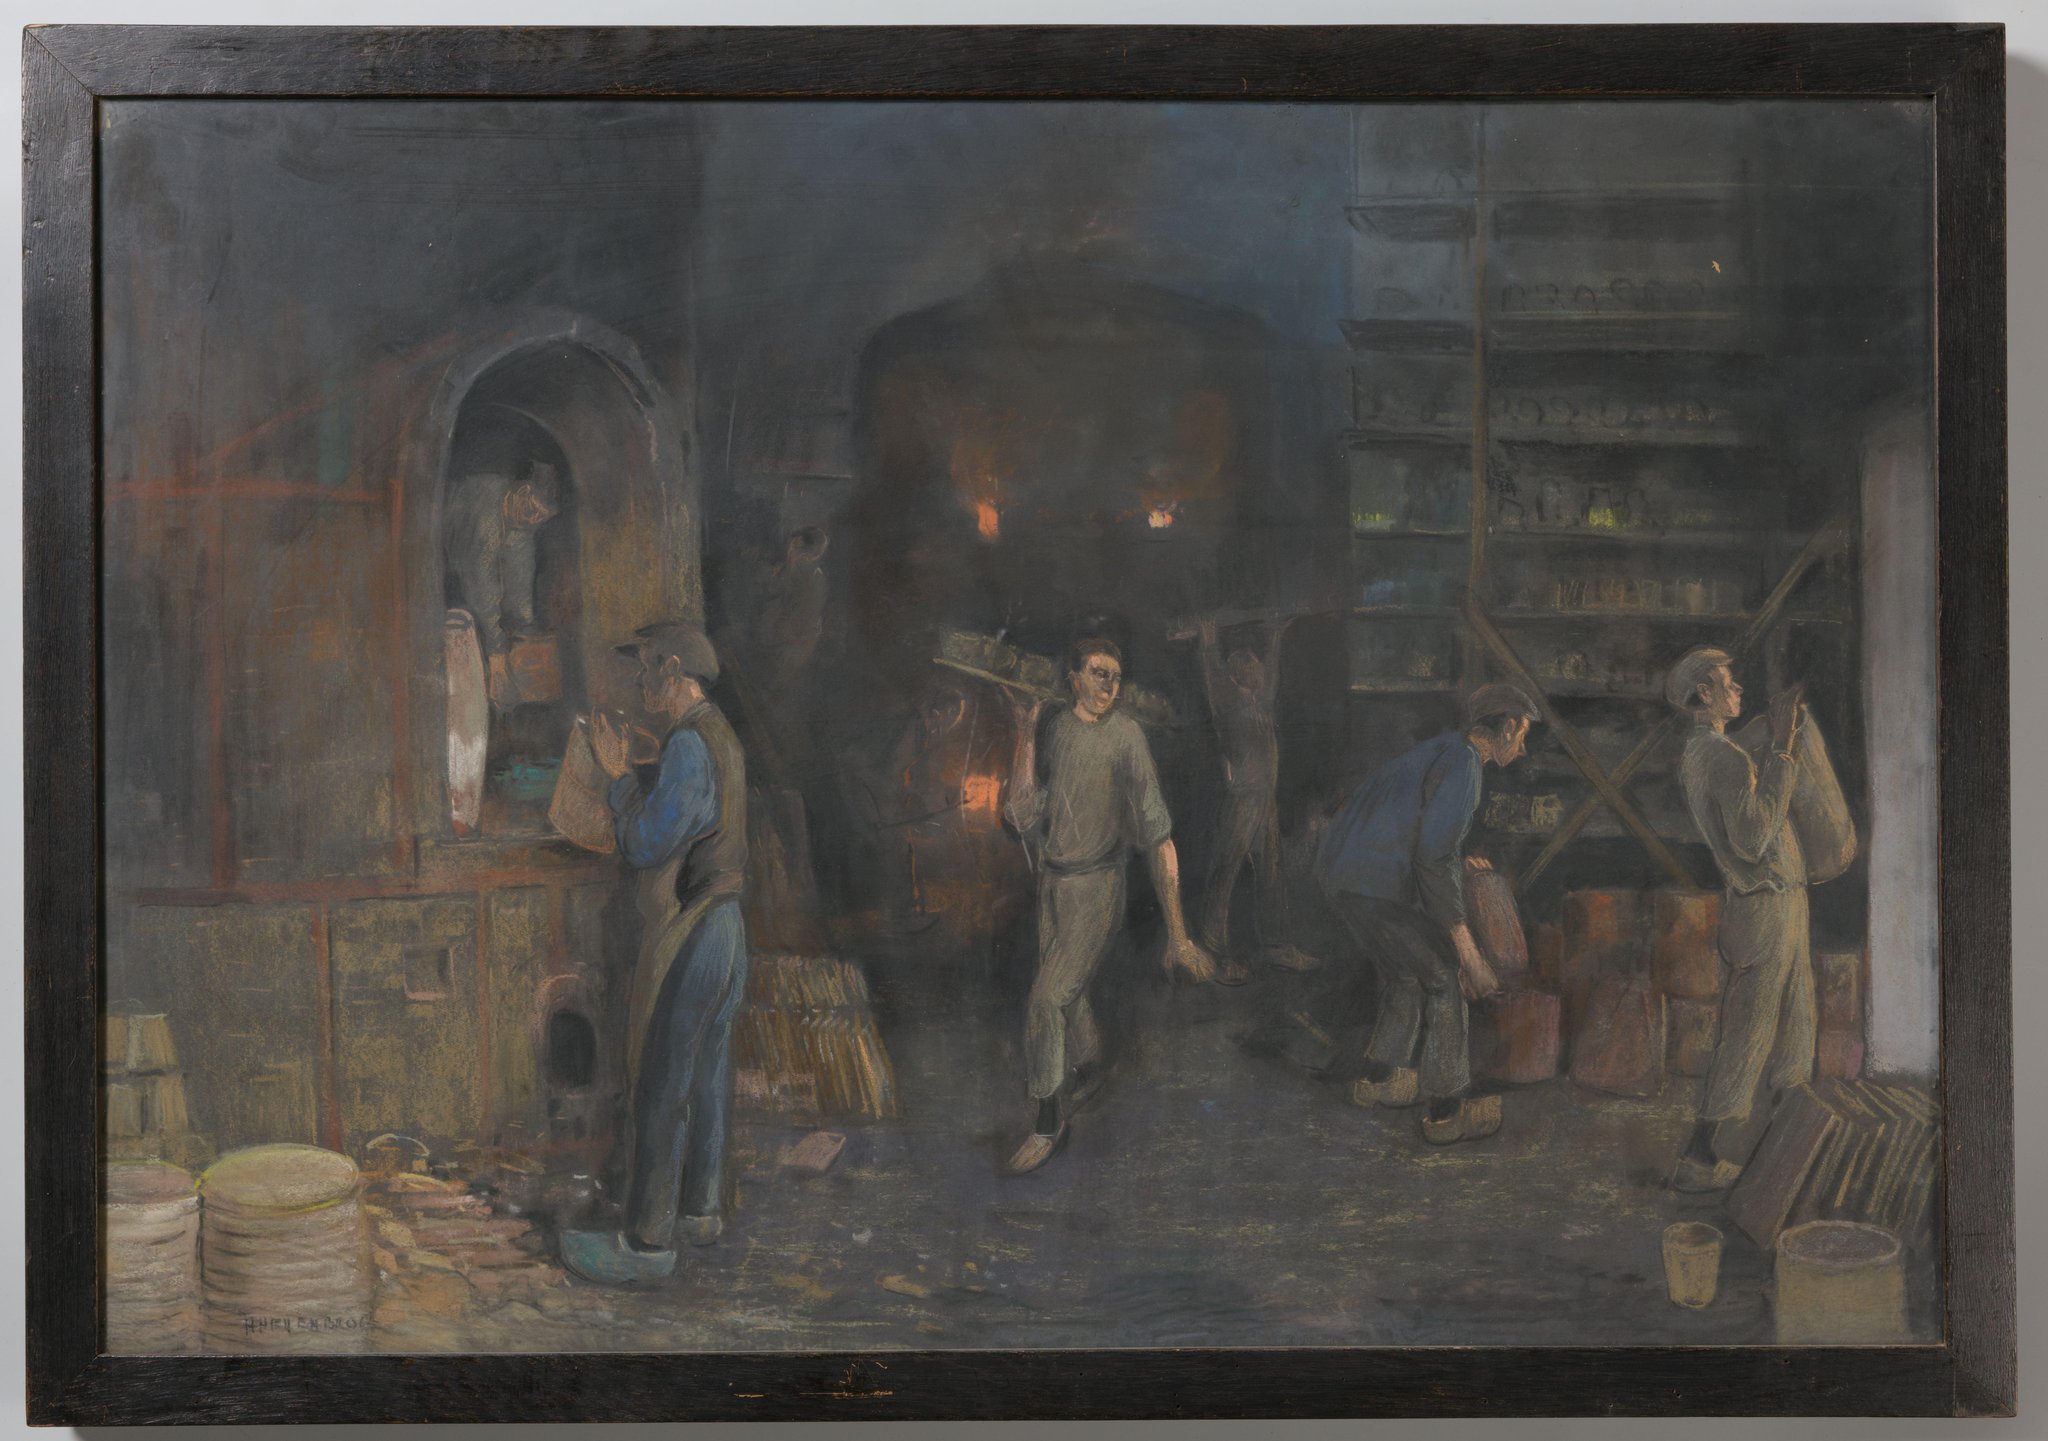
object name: drawing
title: De aardewerkfabriek 'Goedewagen' te Gouda: de ovens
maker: herman heijenbrock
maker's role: draughtsman, painter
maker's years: 1871-1948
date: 1871-1948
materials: glass, paper, pastel, wood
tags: gouda